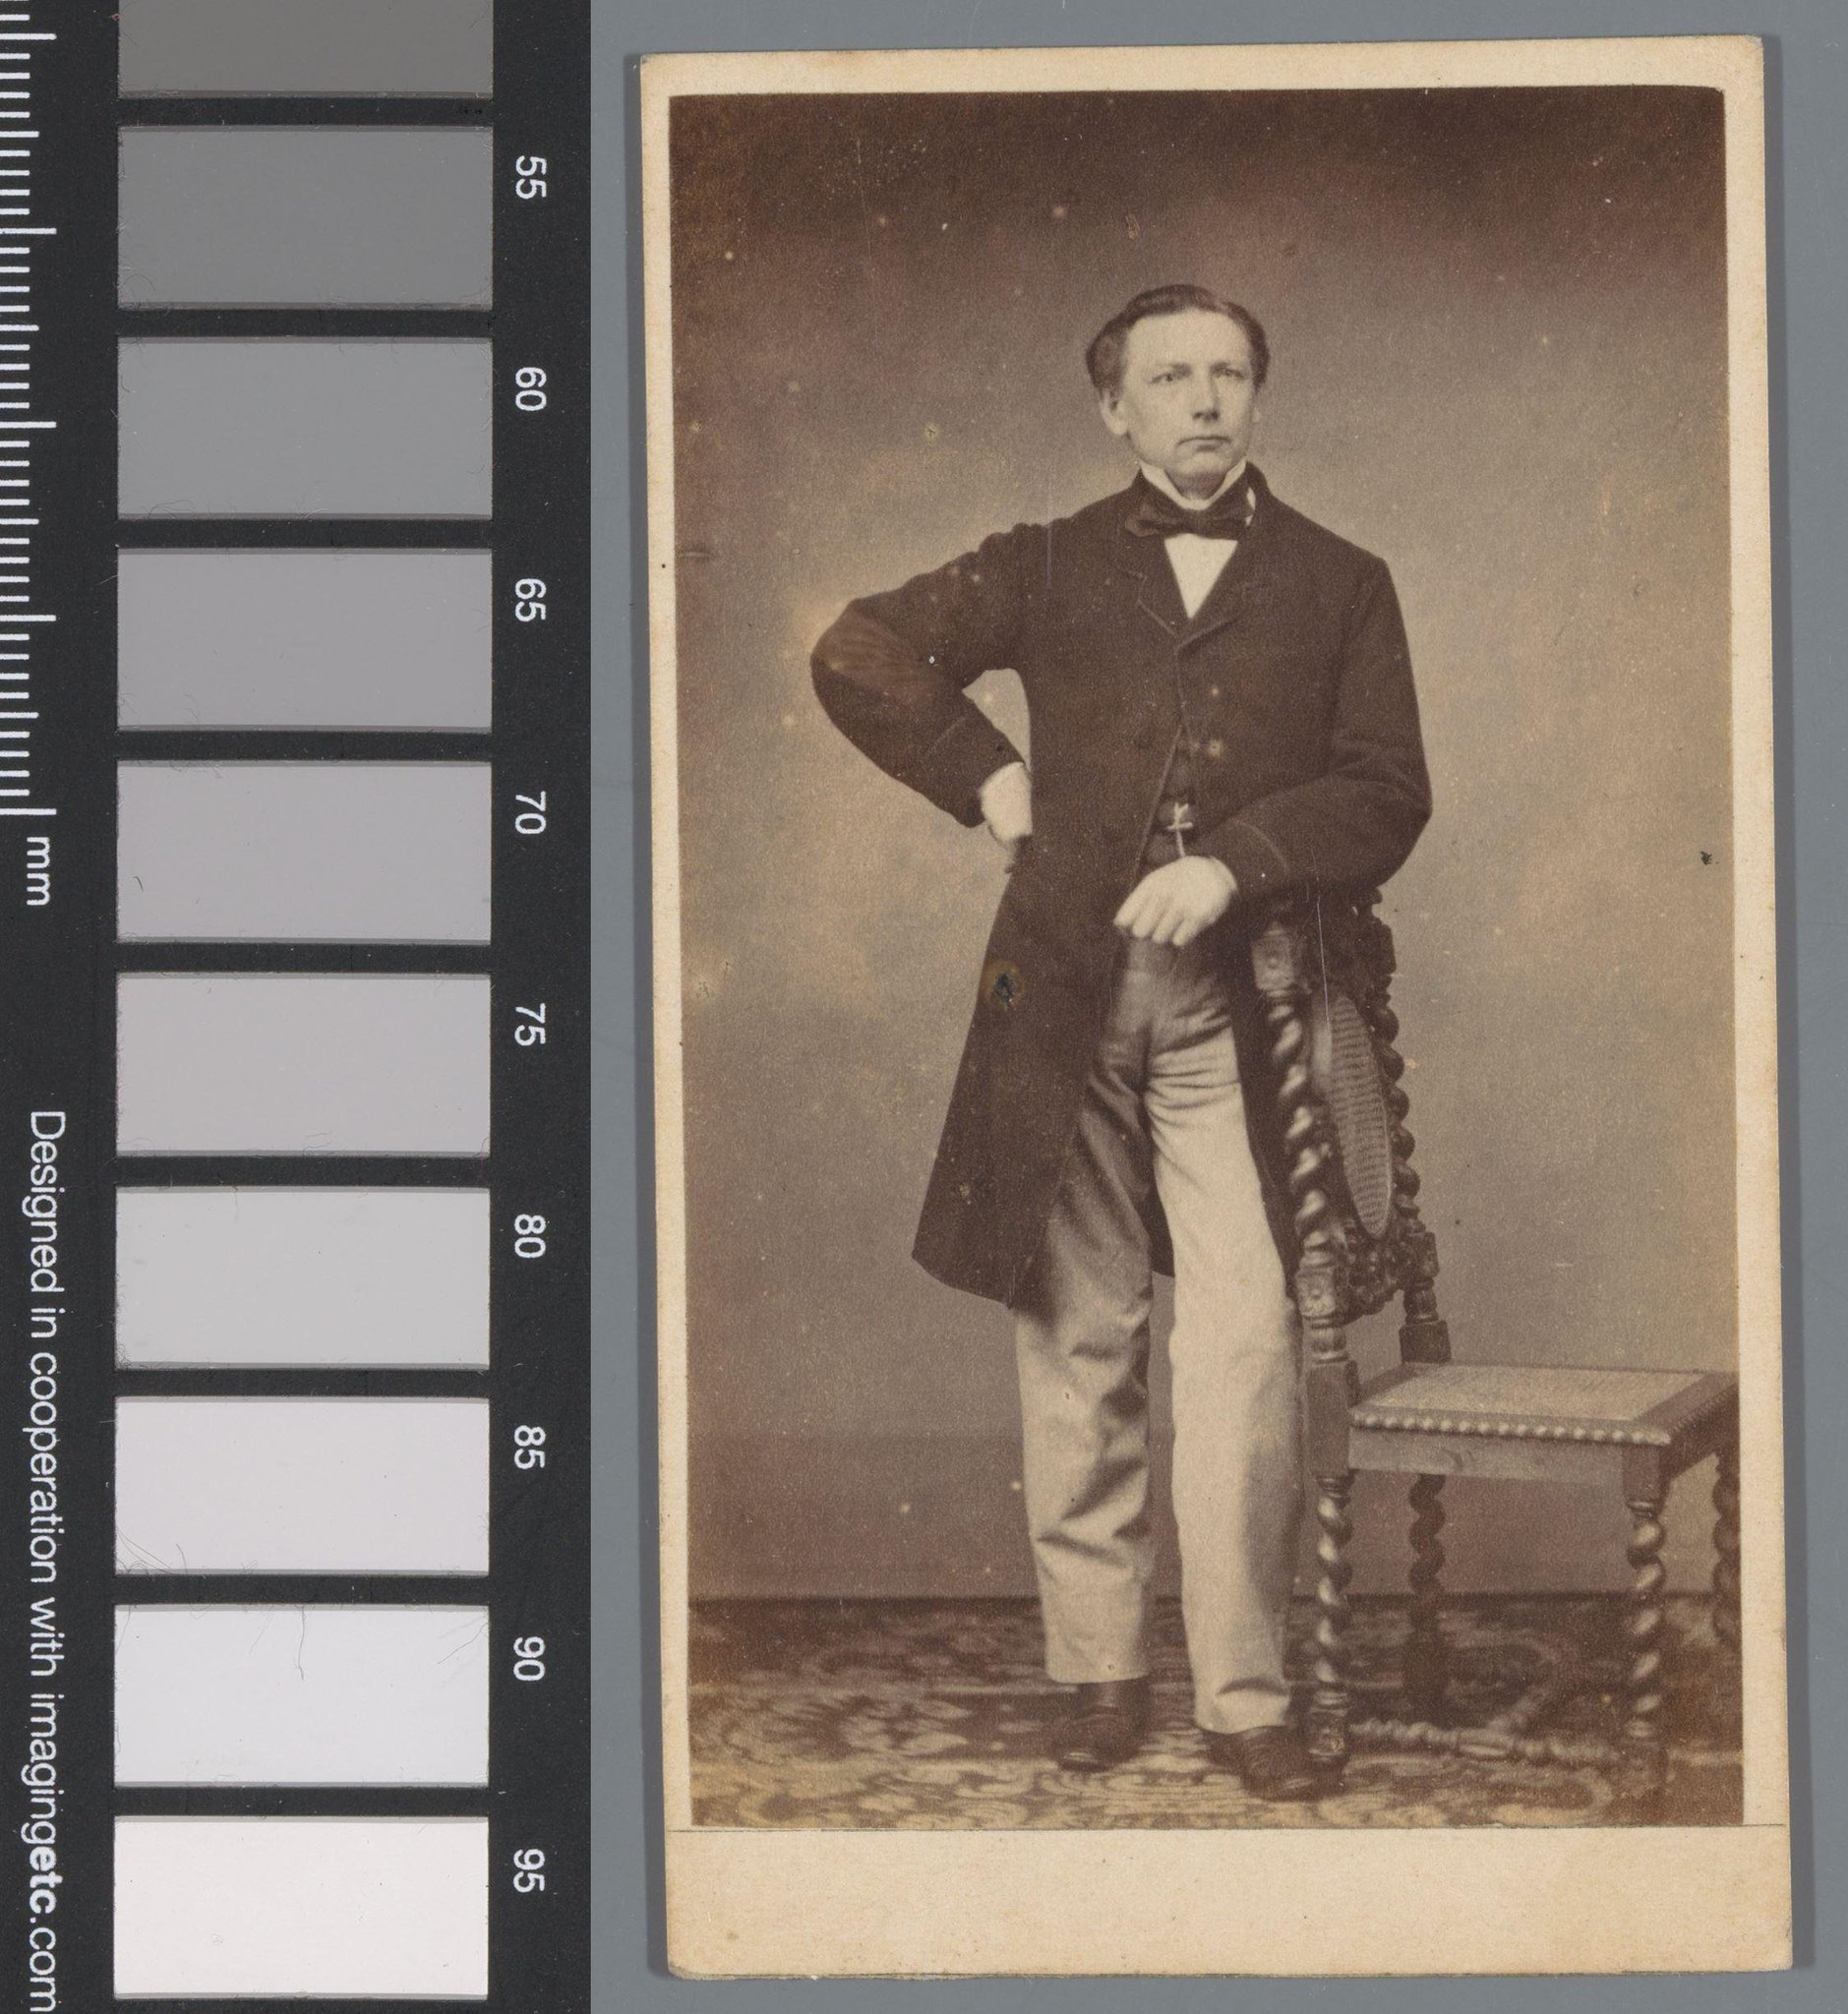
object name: photograph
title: Portret van een onbekende man bij een stoel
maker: willem tinker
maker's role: fotograaf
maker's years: 1816-1894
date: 1860-1880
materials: cardboard, paper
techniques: albumen print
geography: haarlem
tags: adult man, anonymous historical person portrayed, haarlem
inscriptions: inscription: ‘W. Tinker/ Photograaph./ Haarlem’